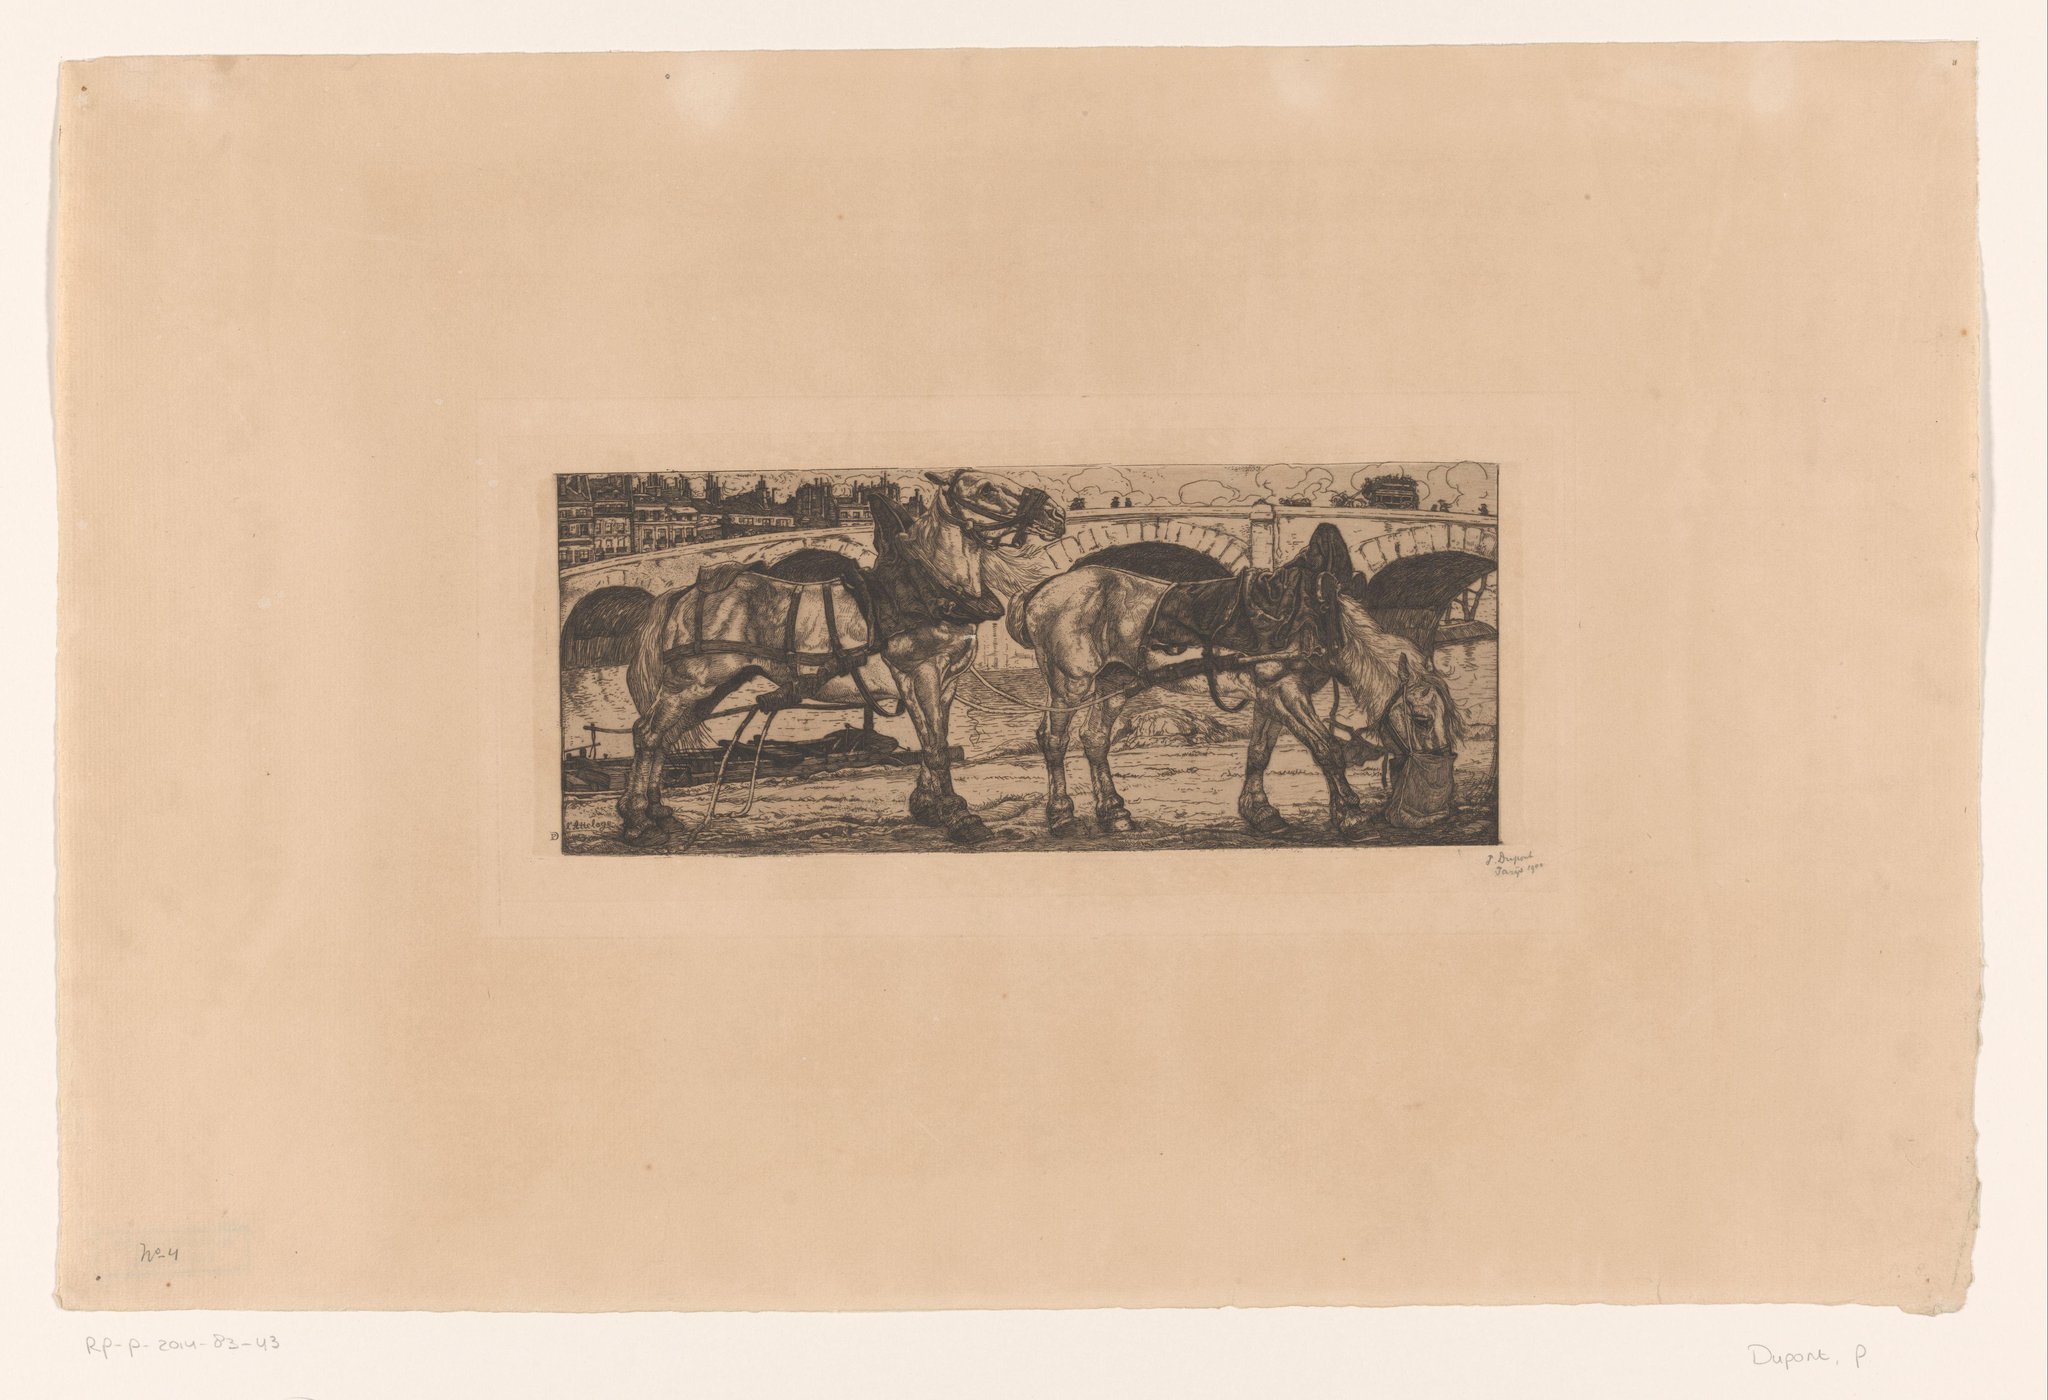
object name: print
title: Paarden aan de Seine in Parijs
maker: pieter dupont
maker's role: draughtsman, print maker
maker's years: 1870-1911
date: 1900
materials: paper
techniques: etching, intaglio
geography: paris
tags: horse, bridge in city across river, canal, etc.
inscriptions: collector's mark: Lugt 2228, inscription: ‘No. 4’, collector's mark: Lugt 288, watermark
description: Twee ploegpaarden aan de Seine in Parijs